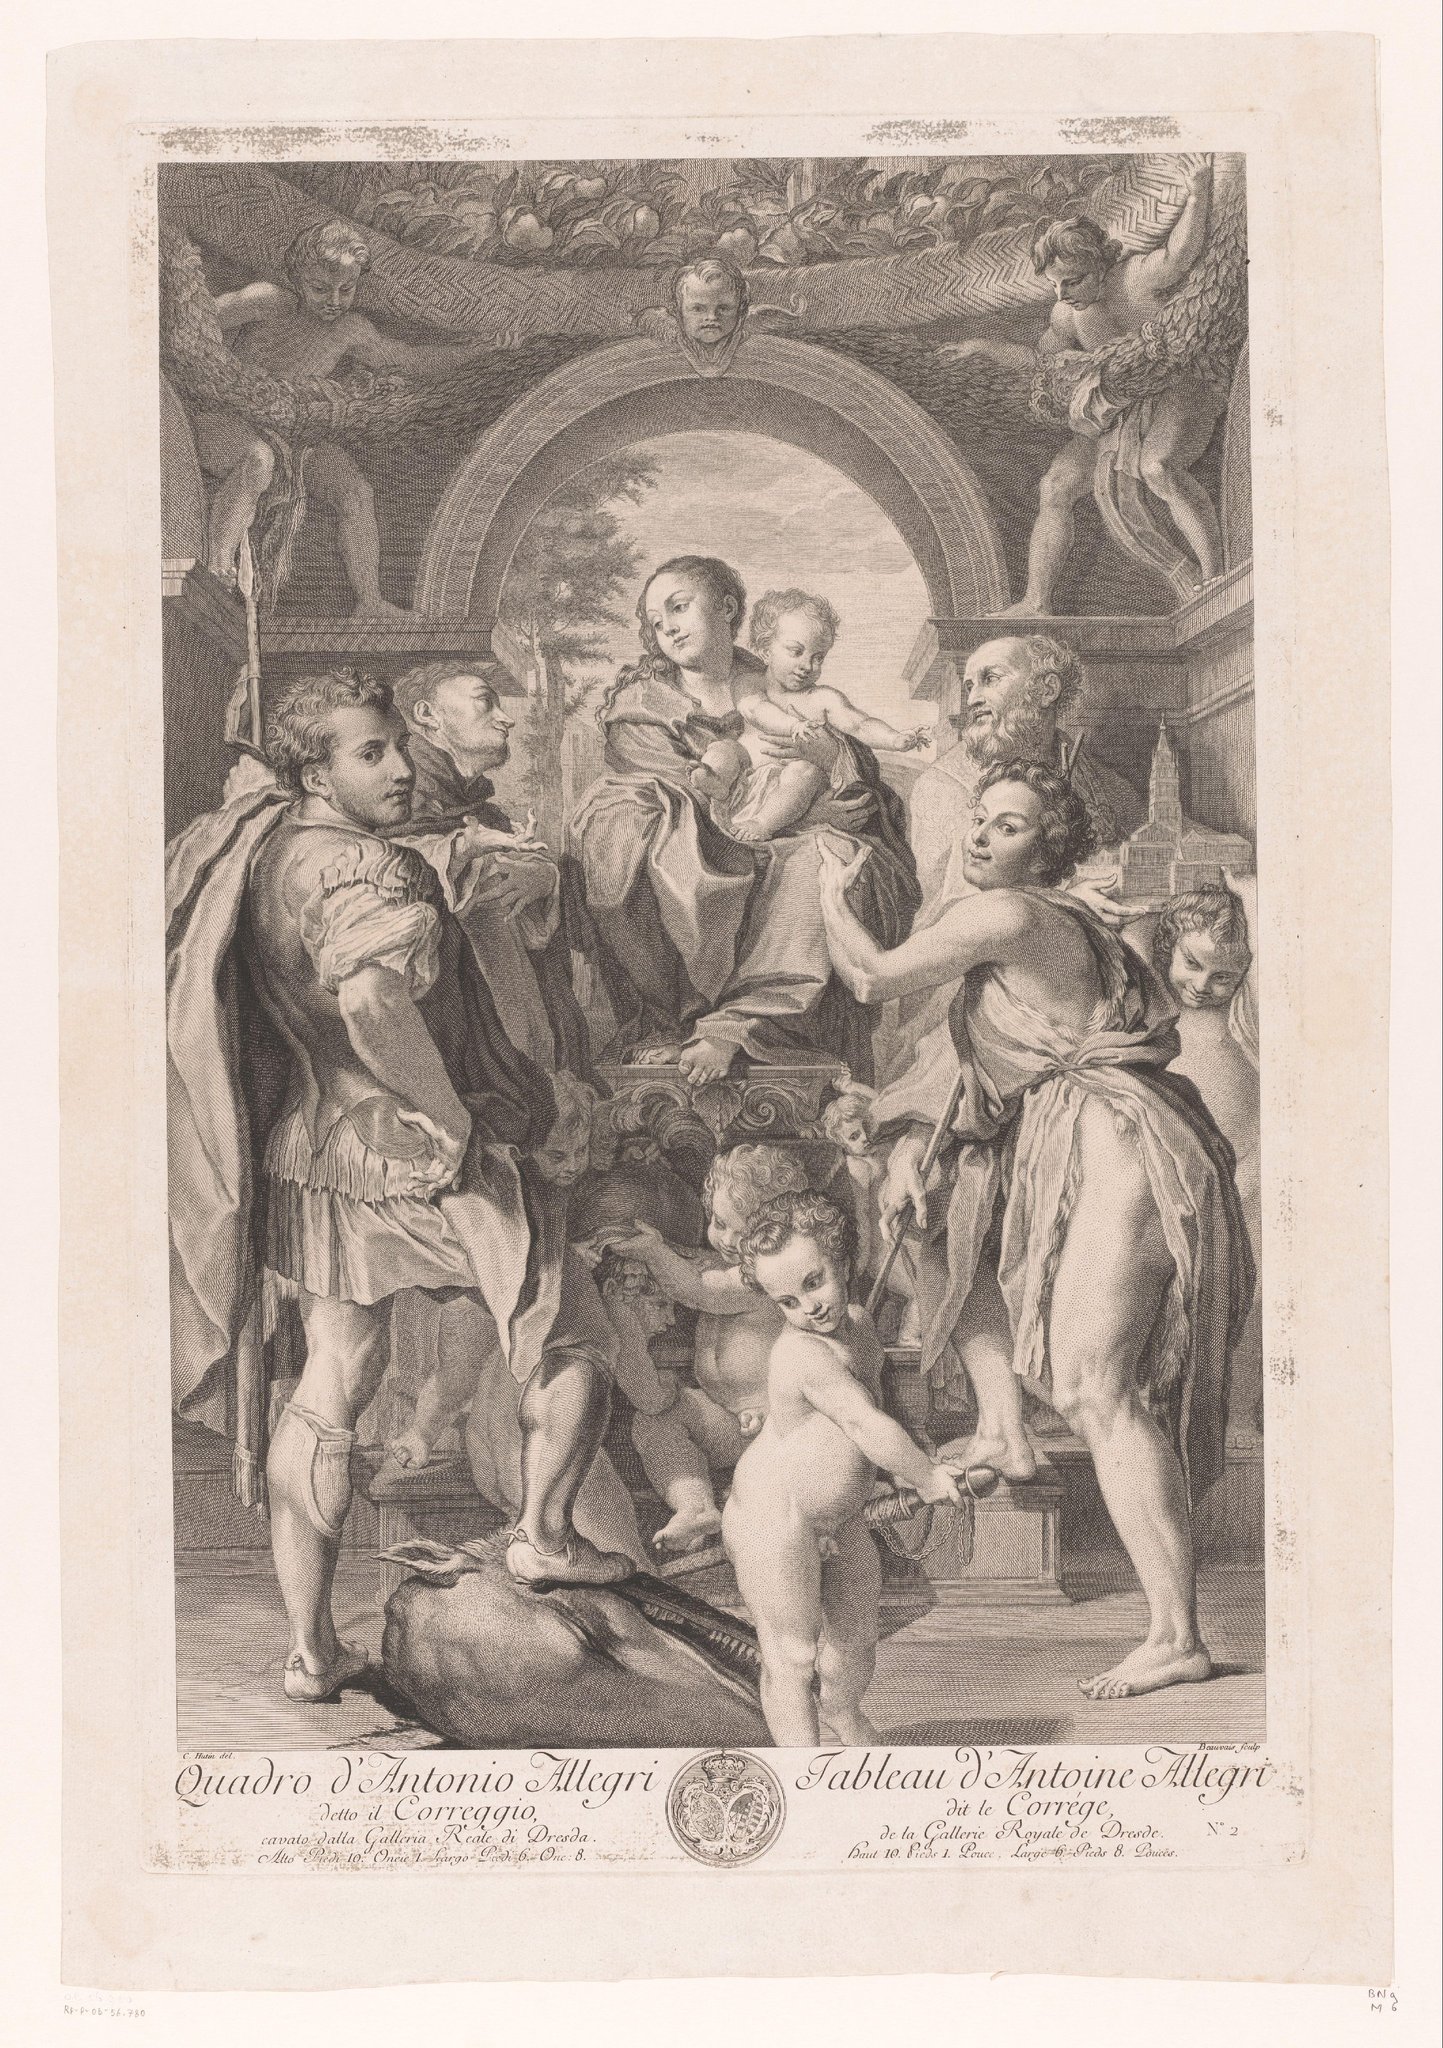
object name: print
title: Recueil d'estampes d'après les plus célèbres tableaux de la Galerie Royale de Dresde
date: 1750-1753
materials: paper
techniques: engraving, etching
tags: mary sitting or enthroned, the christ-child in front of her in her lap (or in front of her bosom), series of scenes from the life of john the baptist, the warrior martyr george (georgius); possible attributes: banner (red cross on white field), (red) cross, dragon, (white) horse, broken lance, shield (with cross), sword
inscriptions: collector's mark: Lugt 2228